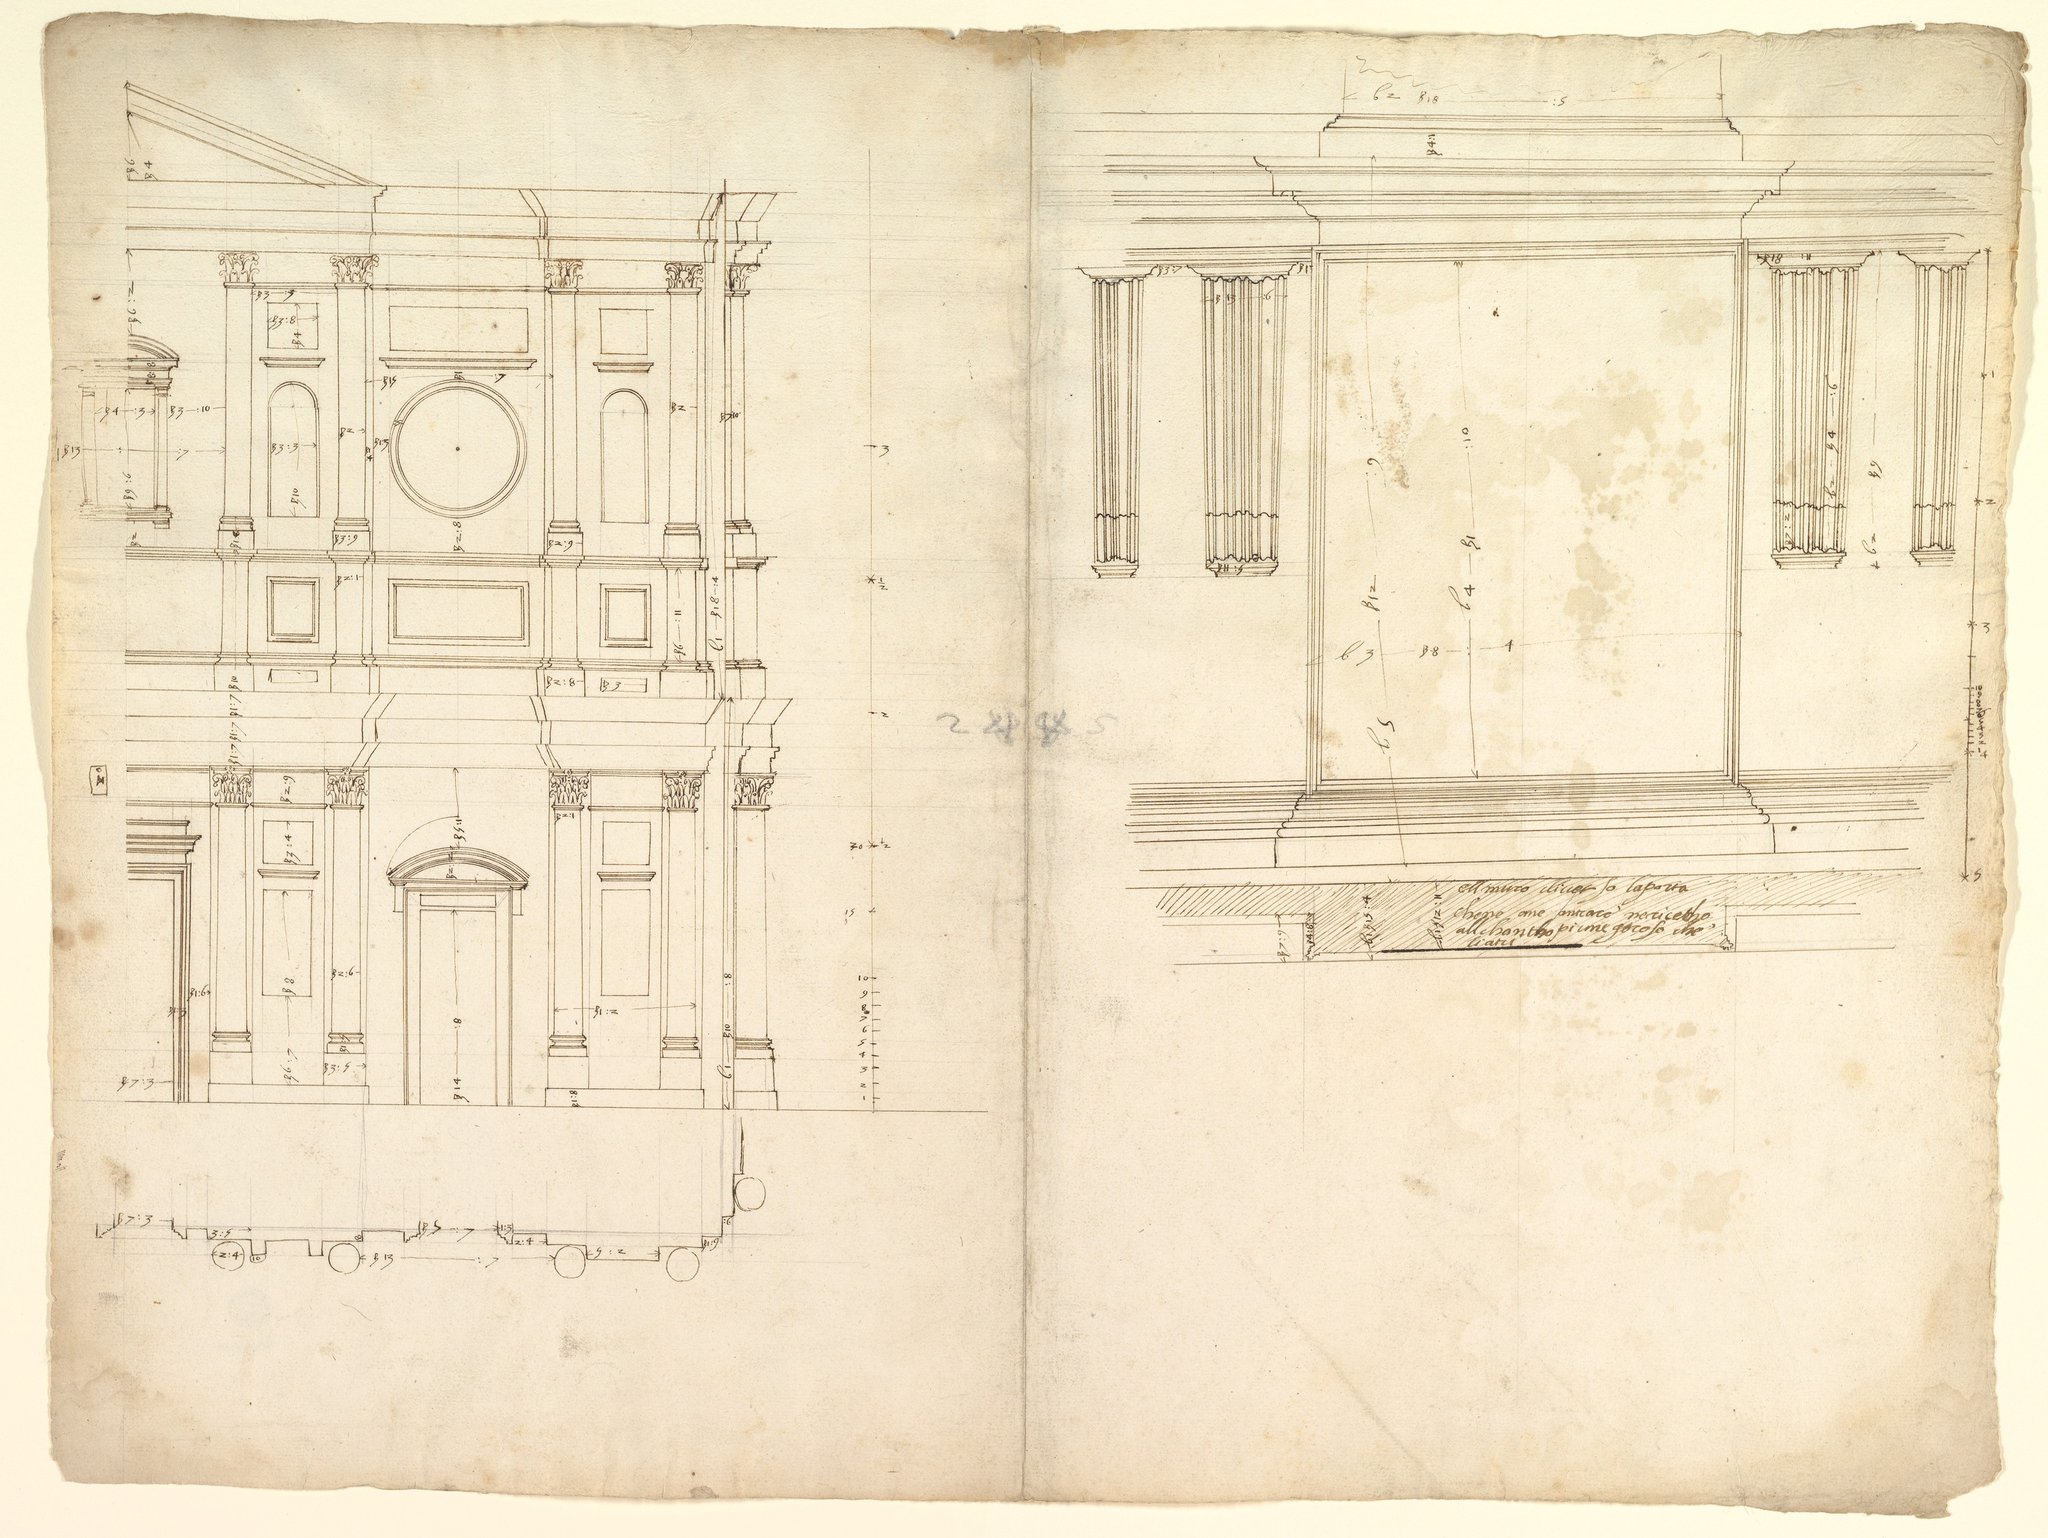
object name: drawing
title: San Lorenzo, model, right half façade (left hand of folio); San Lorenzo, Library, Ricetto, consoles, elevation (right hand) (recto) blank (verso)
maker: anonymous, french, 16th century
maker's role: draftsman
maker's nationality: french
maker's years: 1500-1600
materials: chalk, ink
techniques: incising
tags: architecture